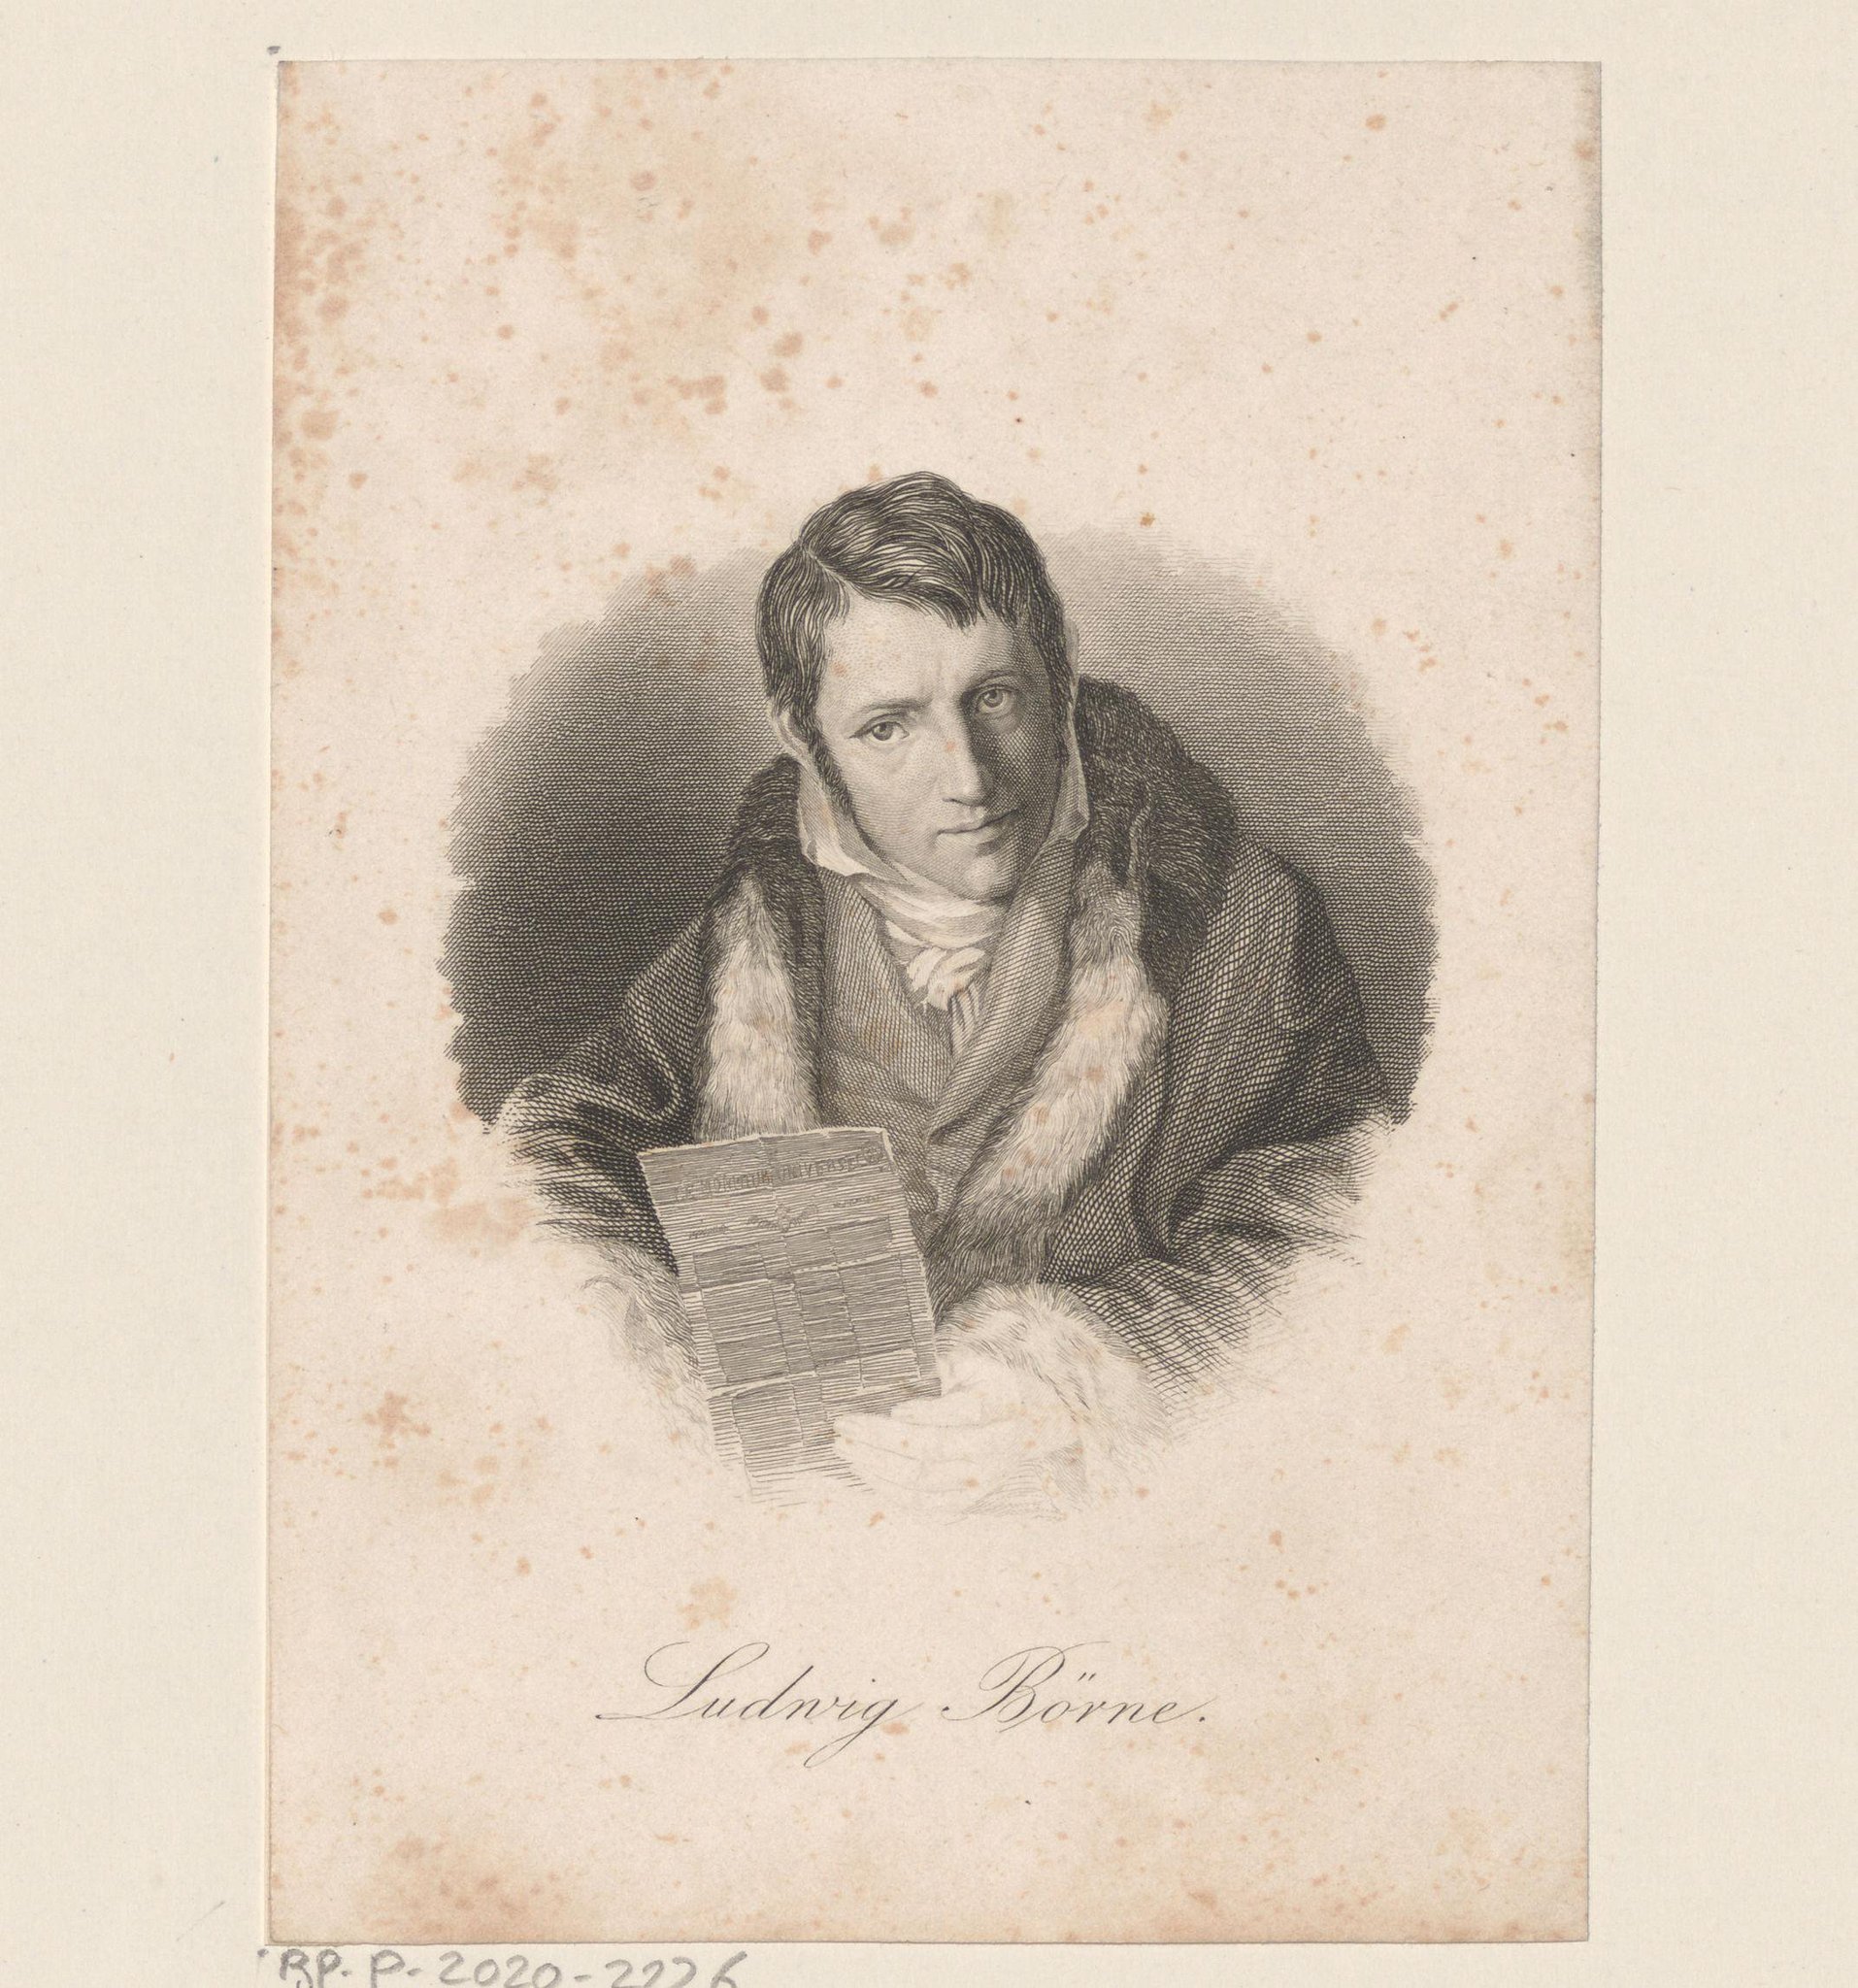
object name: print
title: Portret van Ludwig Börne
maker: Anonymous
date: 1825-1875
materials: paper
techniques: engraving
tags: paris, historical persons, portrait of a writer, single printed leaf: broadsheet, leaflet